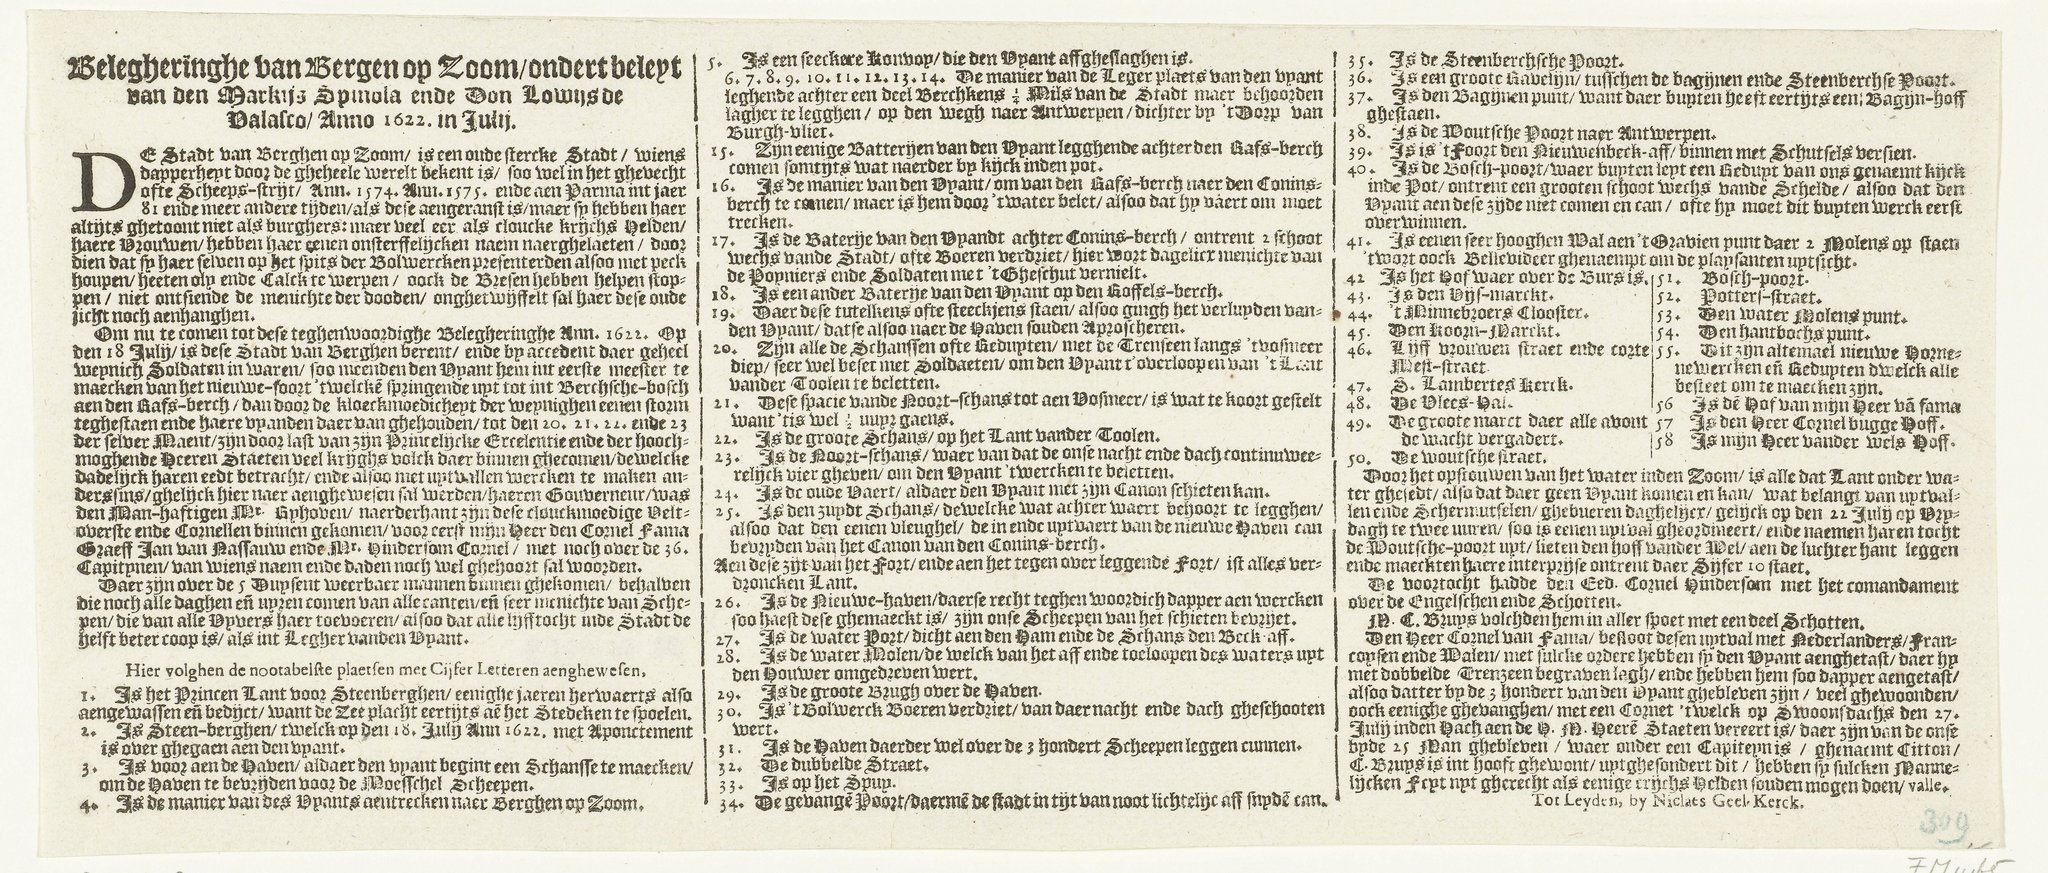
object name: print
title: Beleg van Bergen op Zoom, 1622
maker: nicolaes van geelkercken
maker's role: print maker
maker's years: 1585-1656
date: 1622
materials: paper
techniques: letterpress printing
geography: leiden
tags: bergen op zoom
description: Mislukt beleg van Bergen op Zoom door het Spaanse leger onder Spinola en Velasco, 18 juli - 3 oktober 1622. Zie ook de bijbehorende prent.